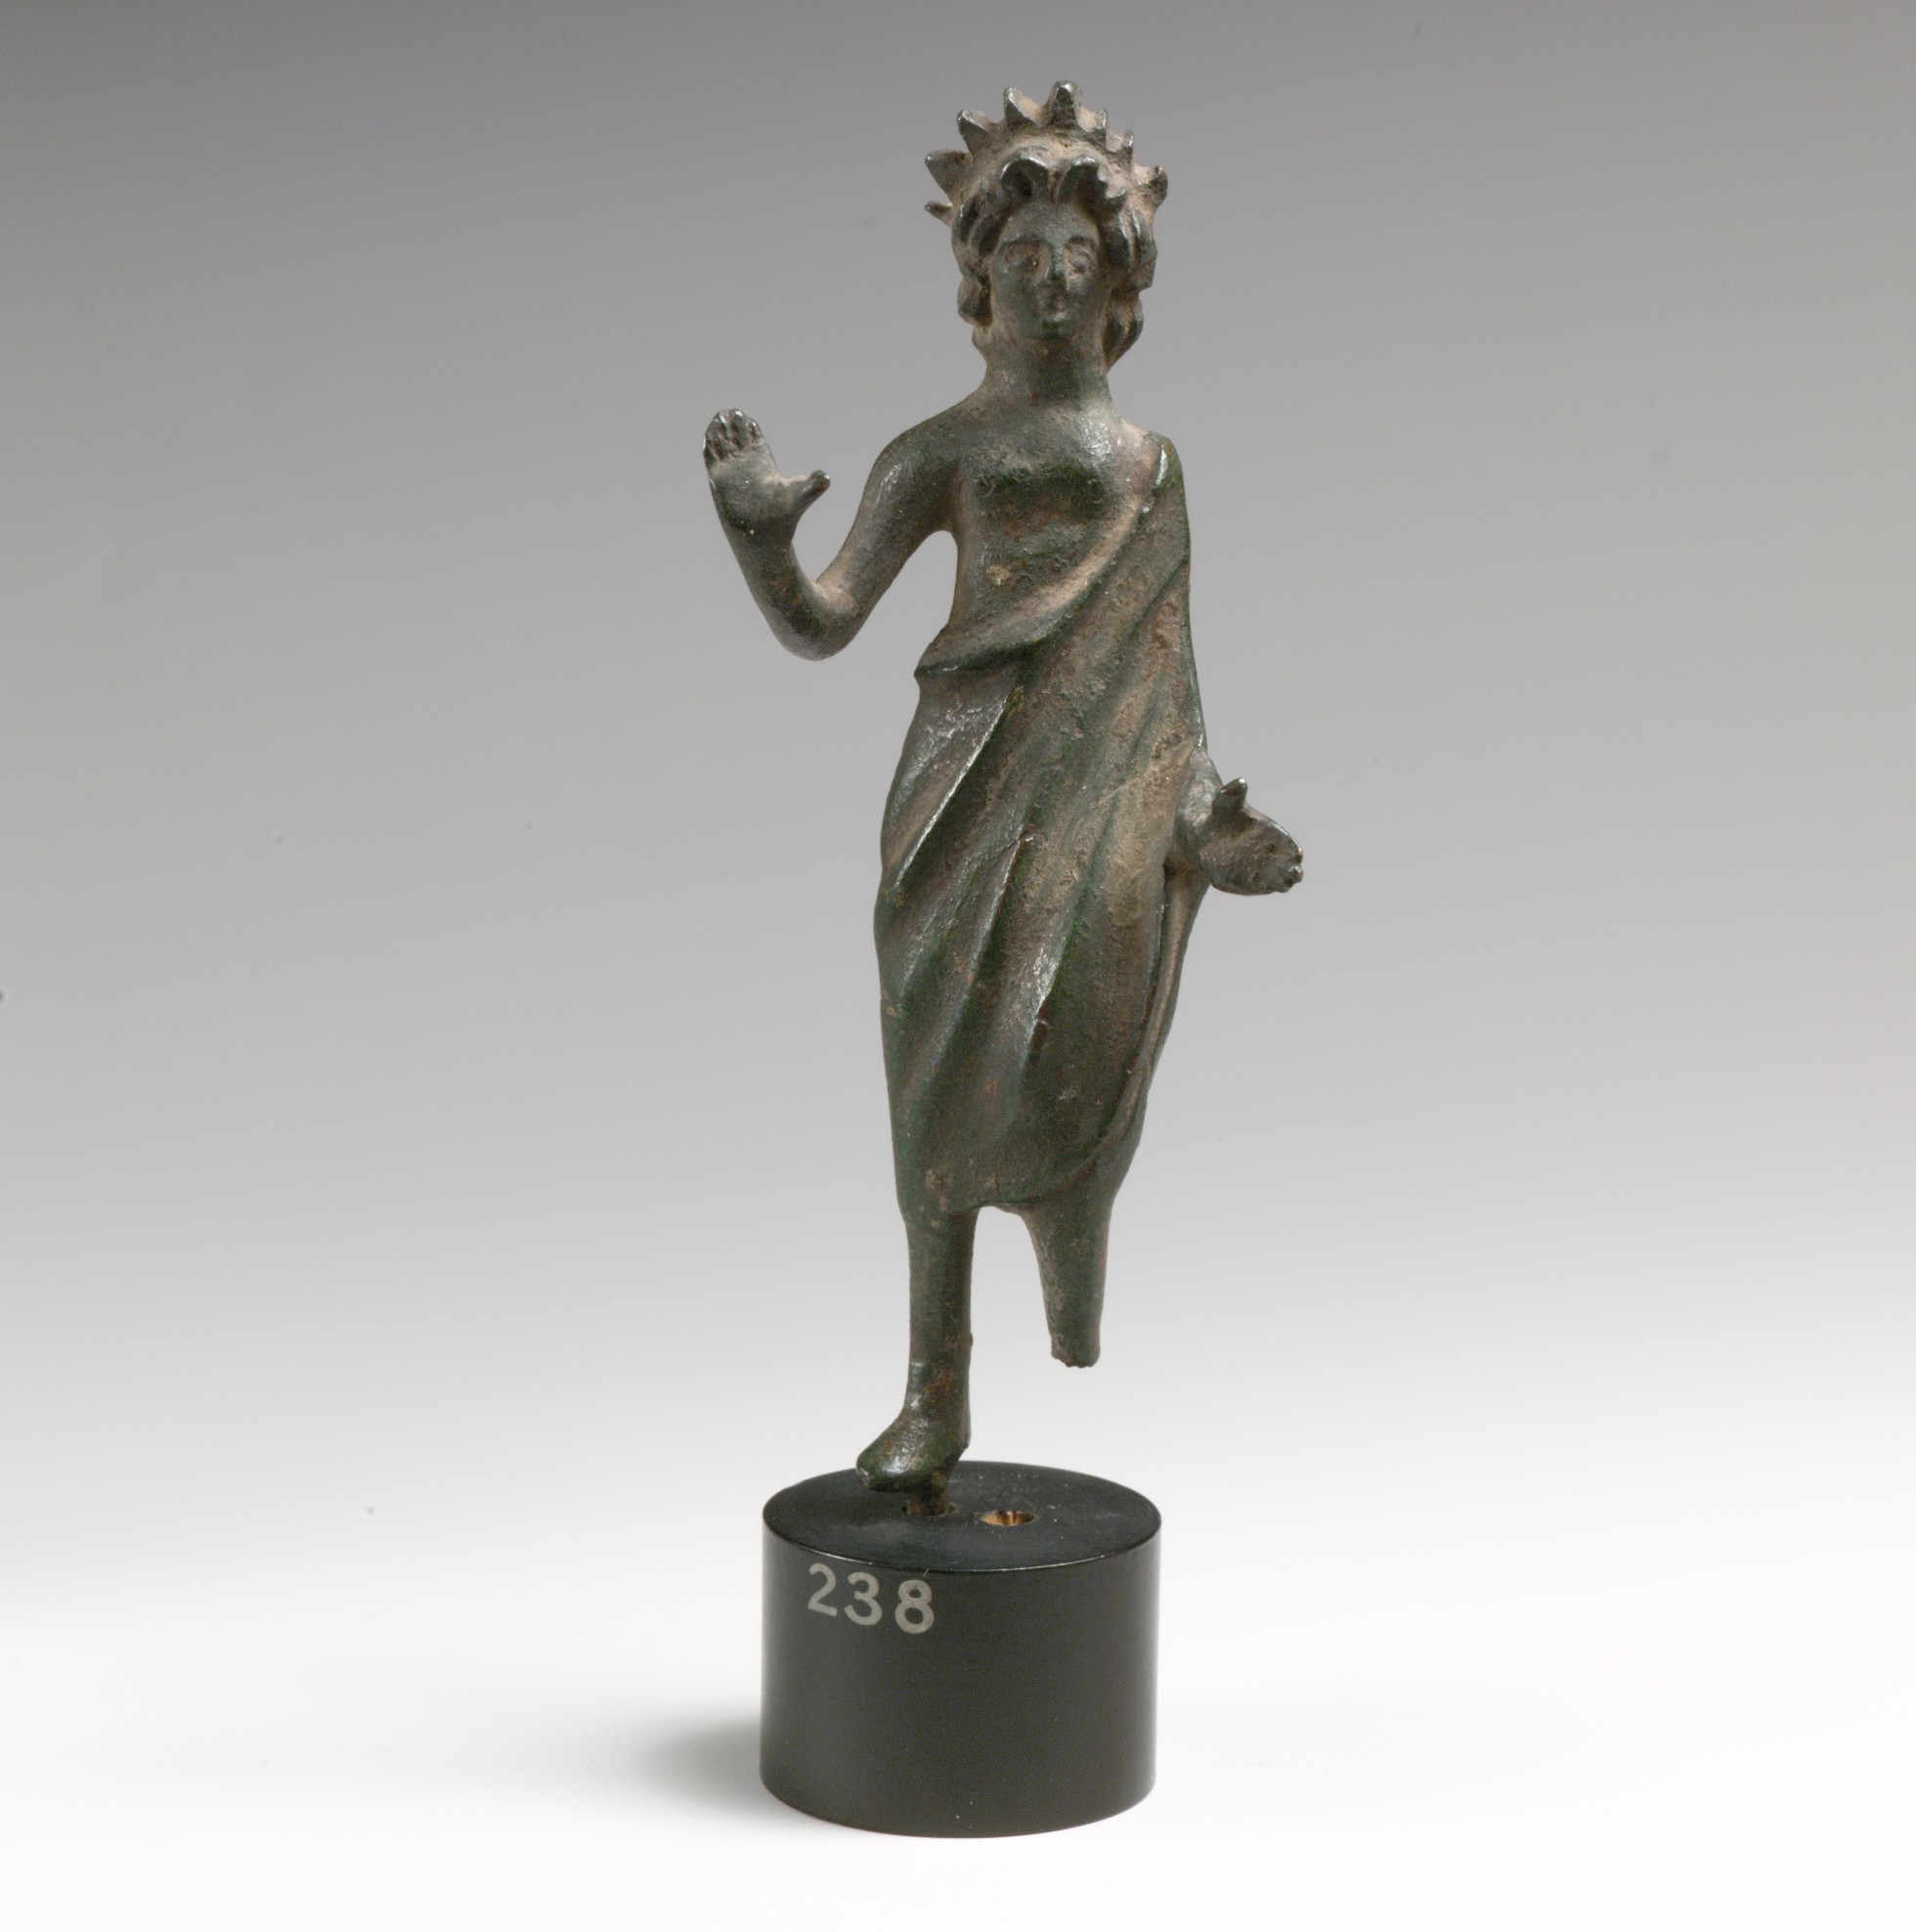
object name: statuette of a man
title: Statuette of a man ?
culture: etruscan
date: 300-1 BCE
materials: bronze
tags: men